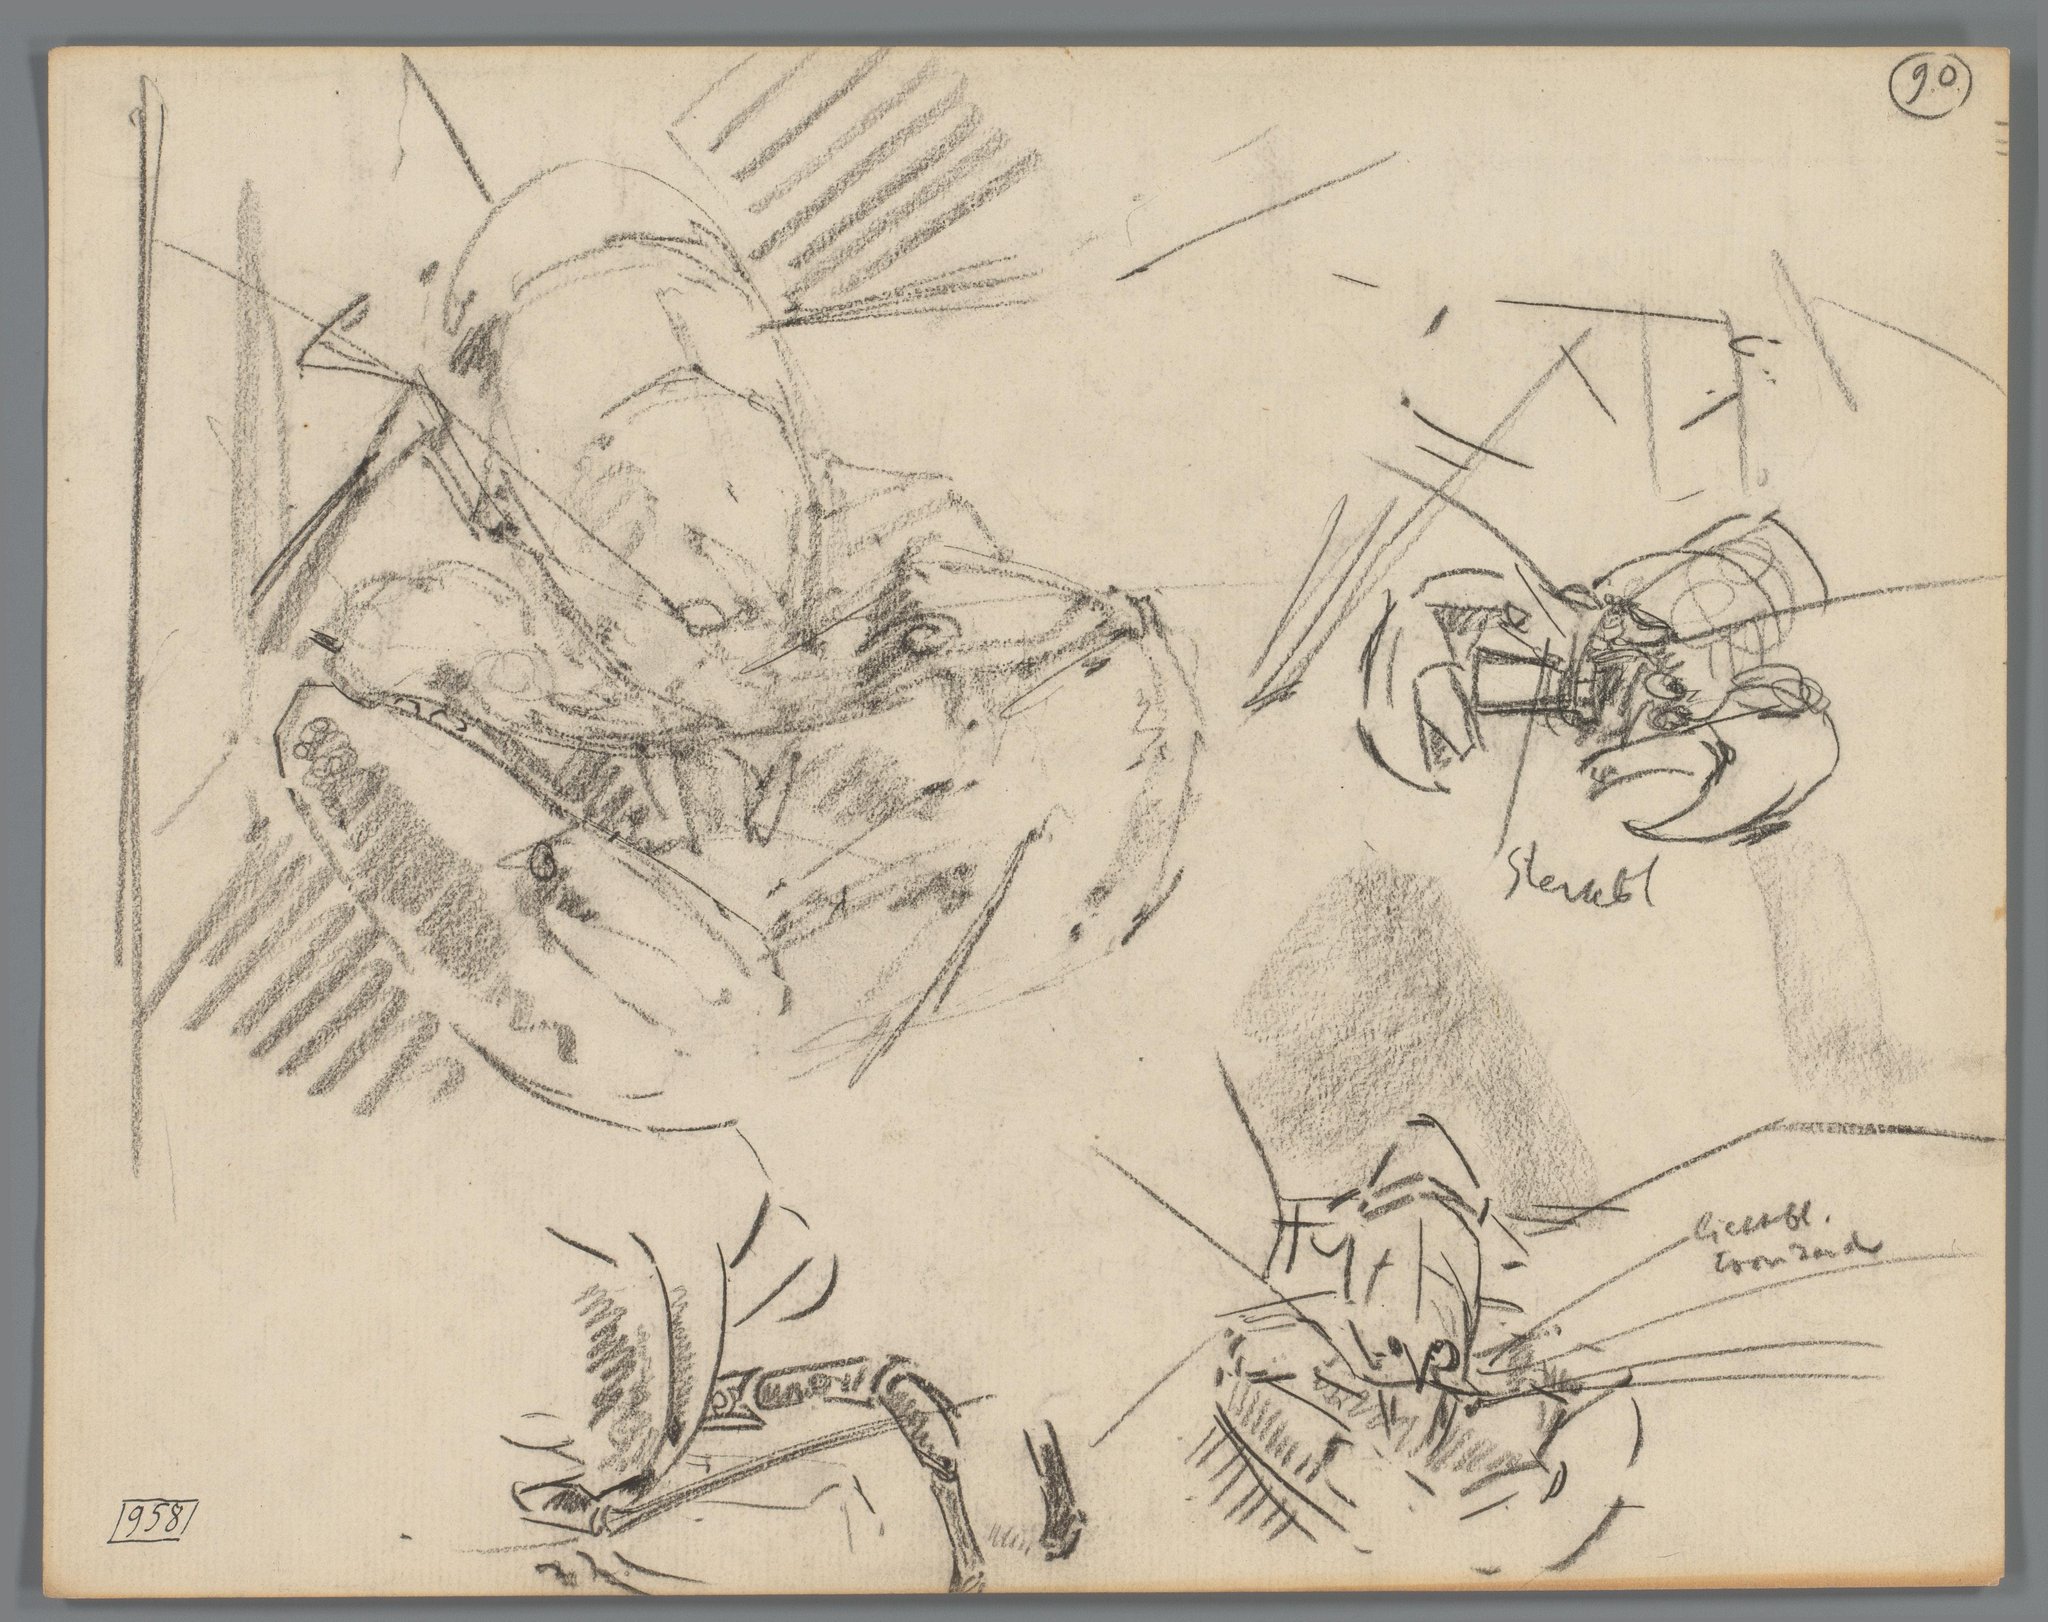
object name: drawing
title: Studies van kreeften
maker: gerrit willem dijsselhof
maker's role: designer, draughtsman, print maker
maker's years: 1866-1924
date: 1876-1924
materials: chalk, paper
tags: crustaceans: lobster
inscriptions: number: ‘958’, number: ‘90’, watermark